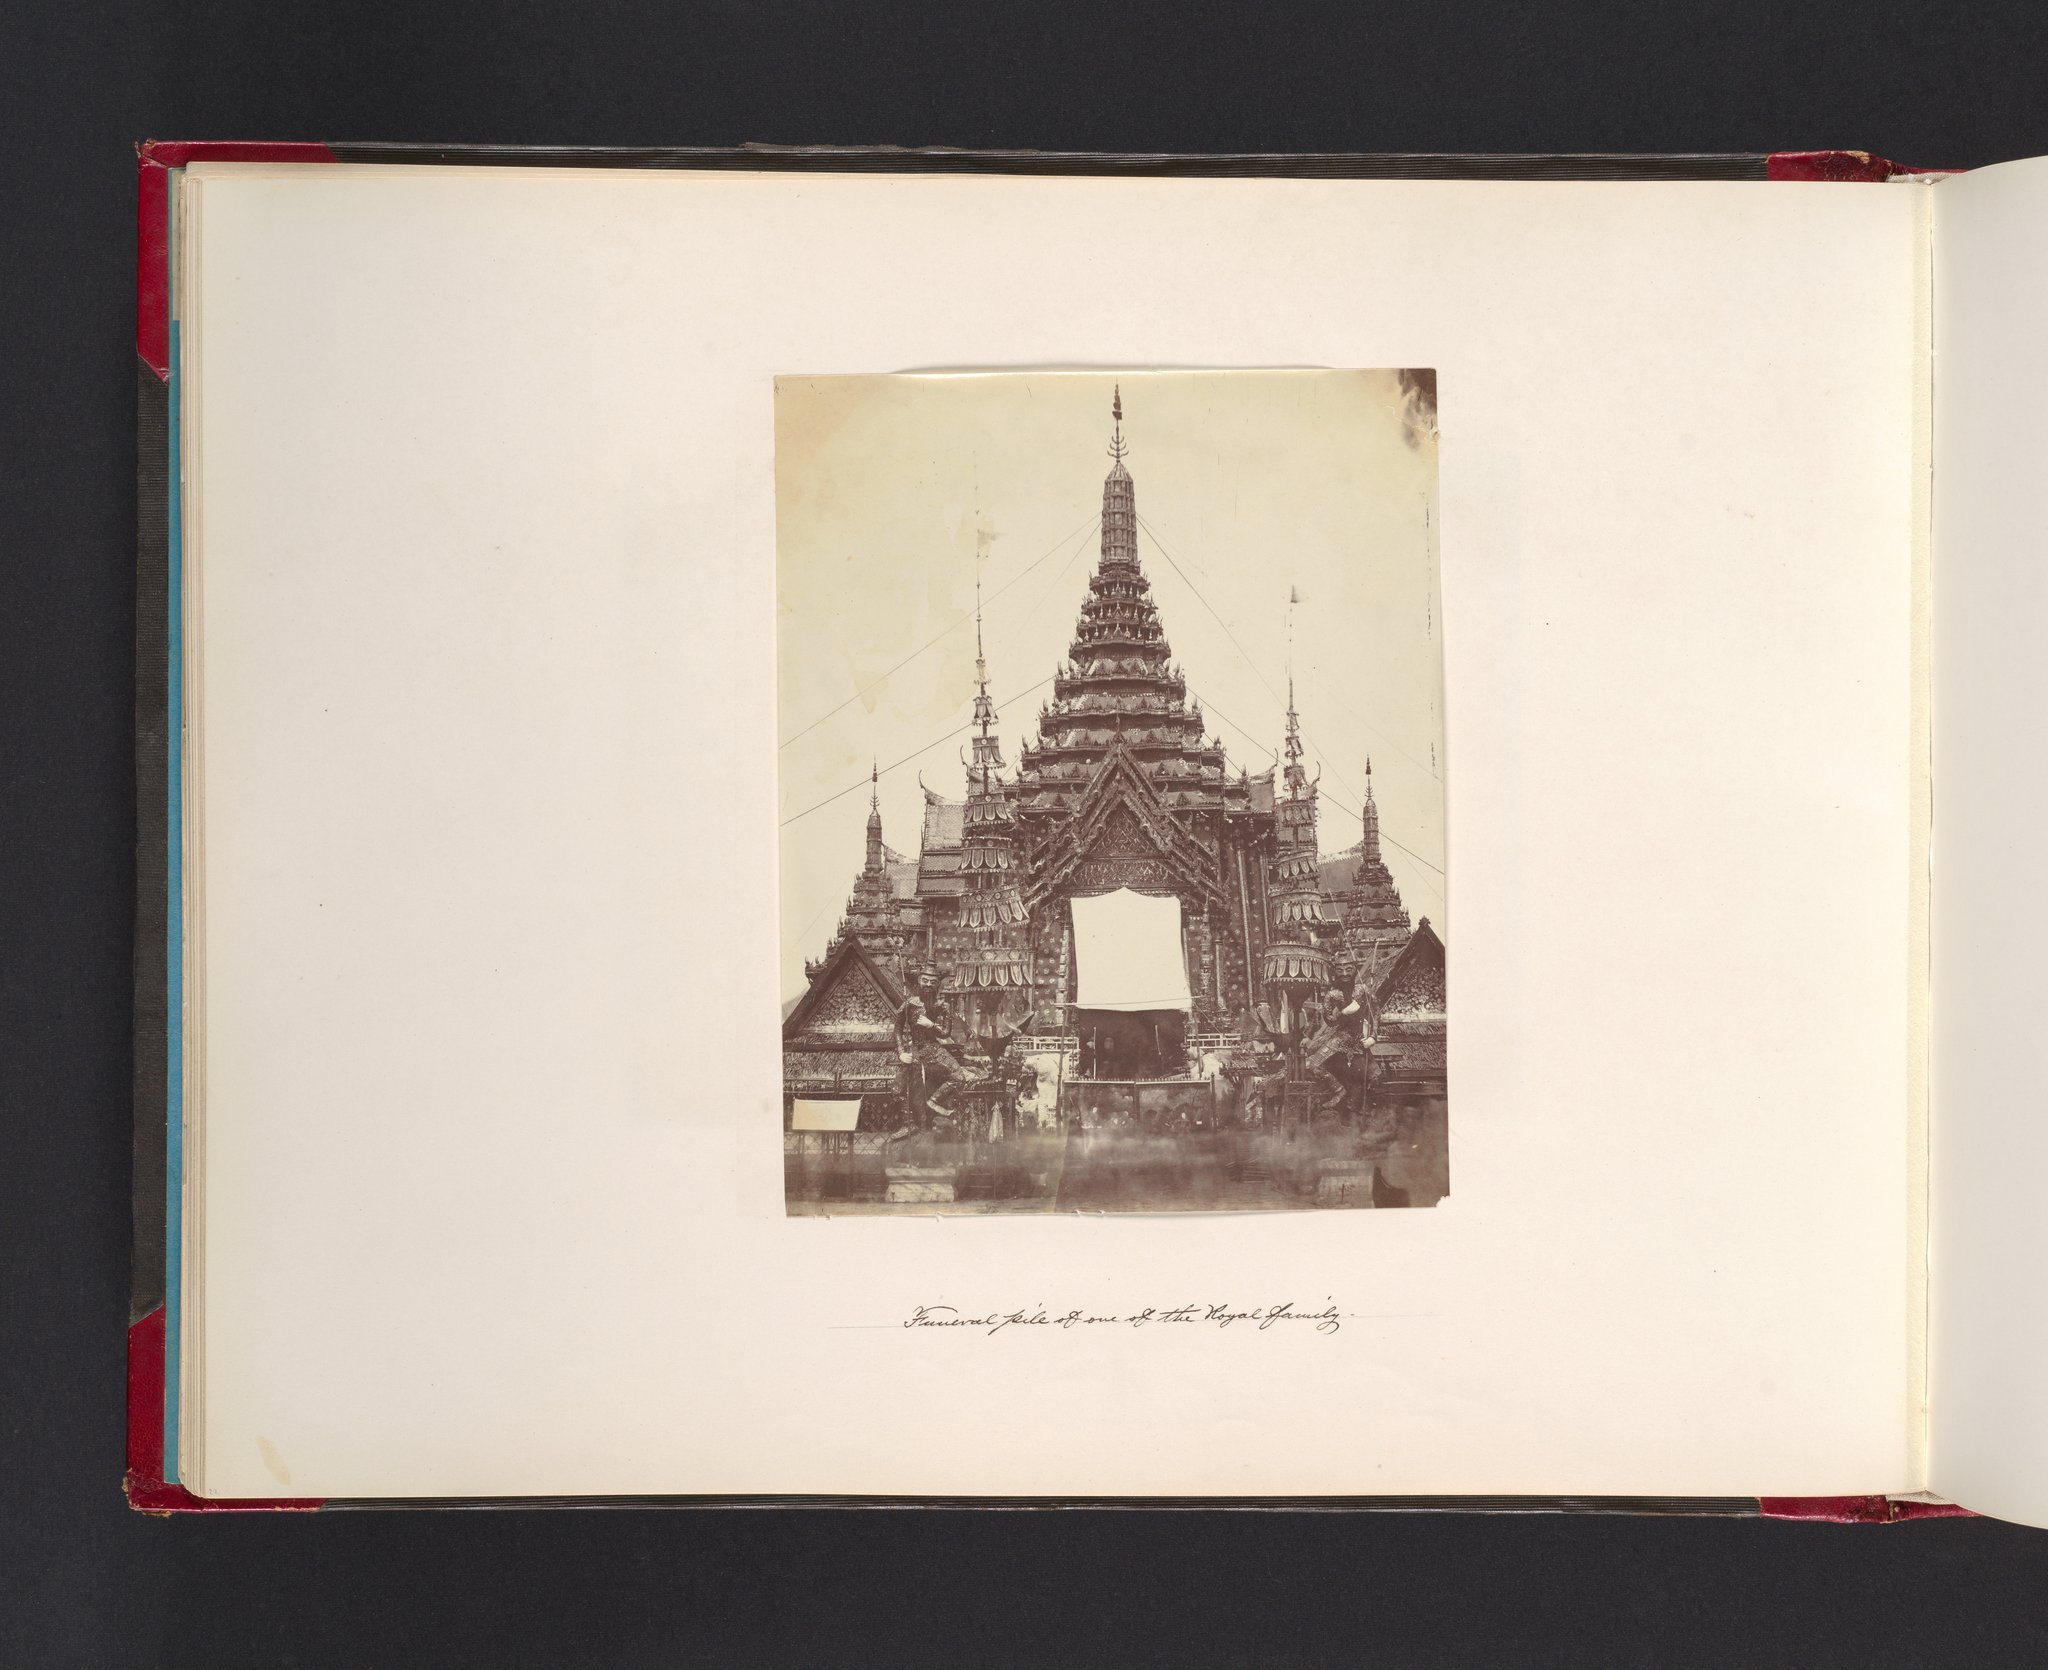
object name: photograph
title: Funeral Pile of One of the Royal Family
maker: john thomson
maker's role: artist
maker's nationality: british, scottish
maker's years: 1837-1921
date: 1865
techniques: albumen silver print, glass negative